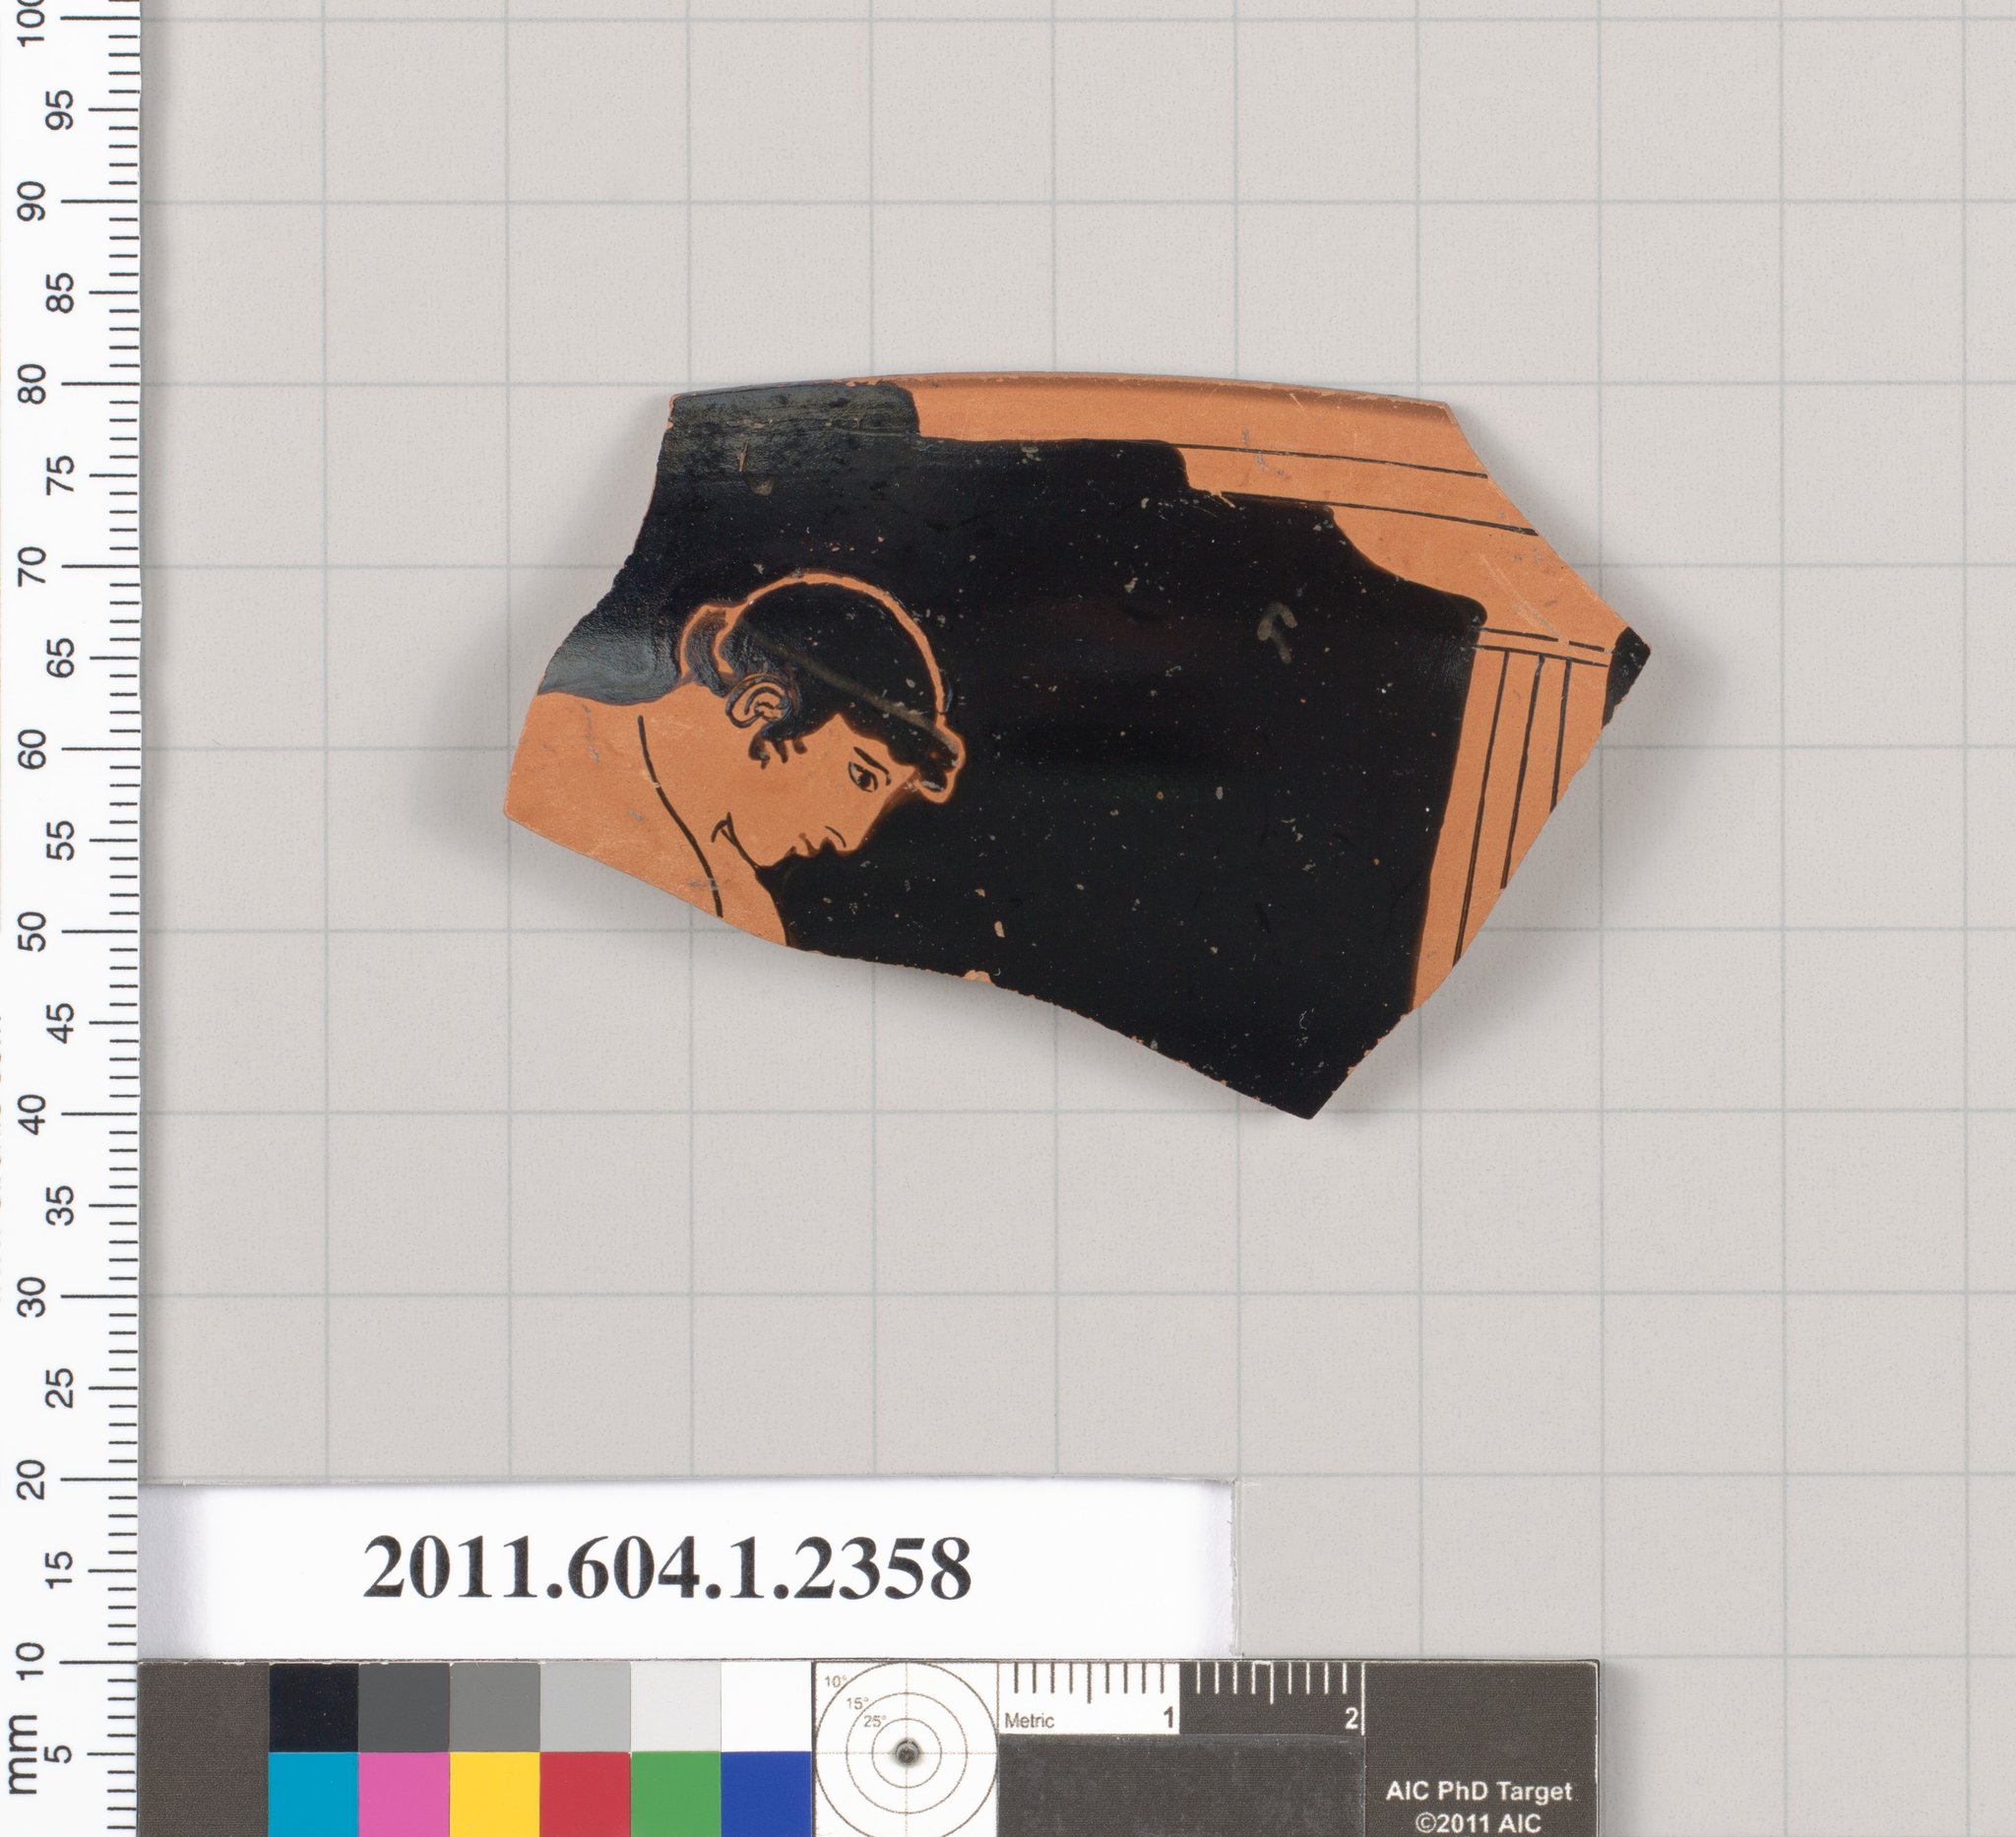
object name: kylix fragment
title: Terracotta rim fragment of a kylix (drinking cup)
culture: greek, attic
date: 480-470 BCE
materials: terracotta